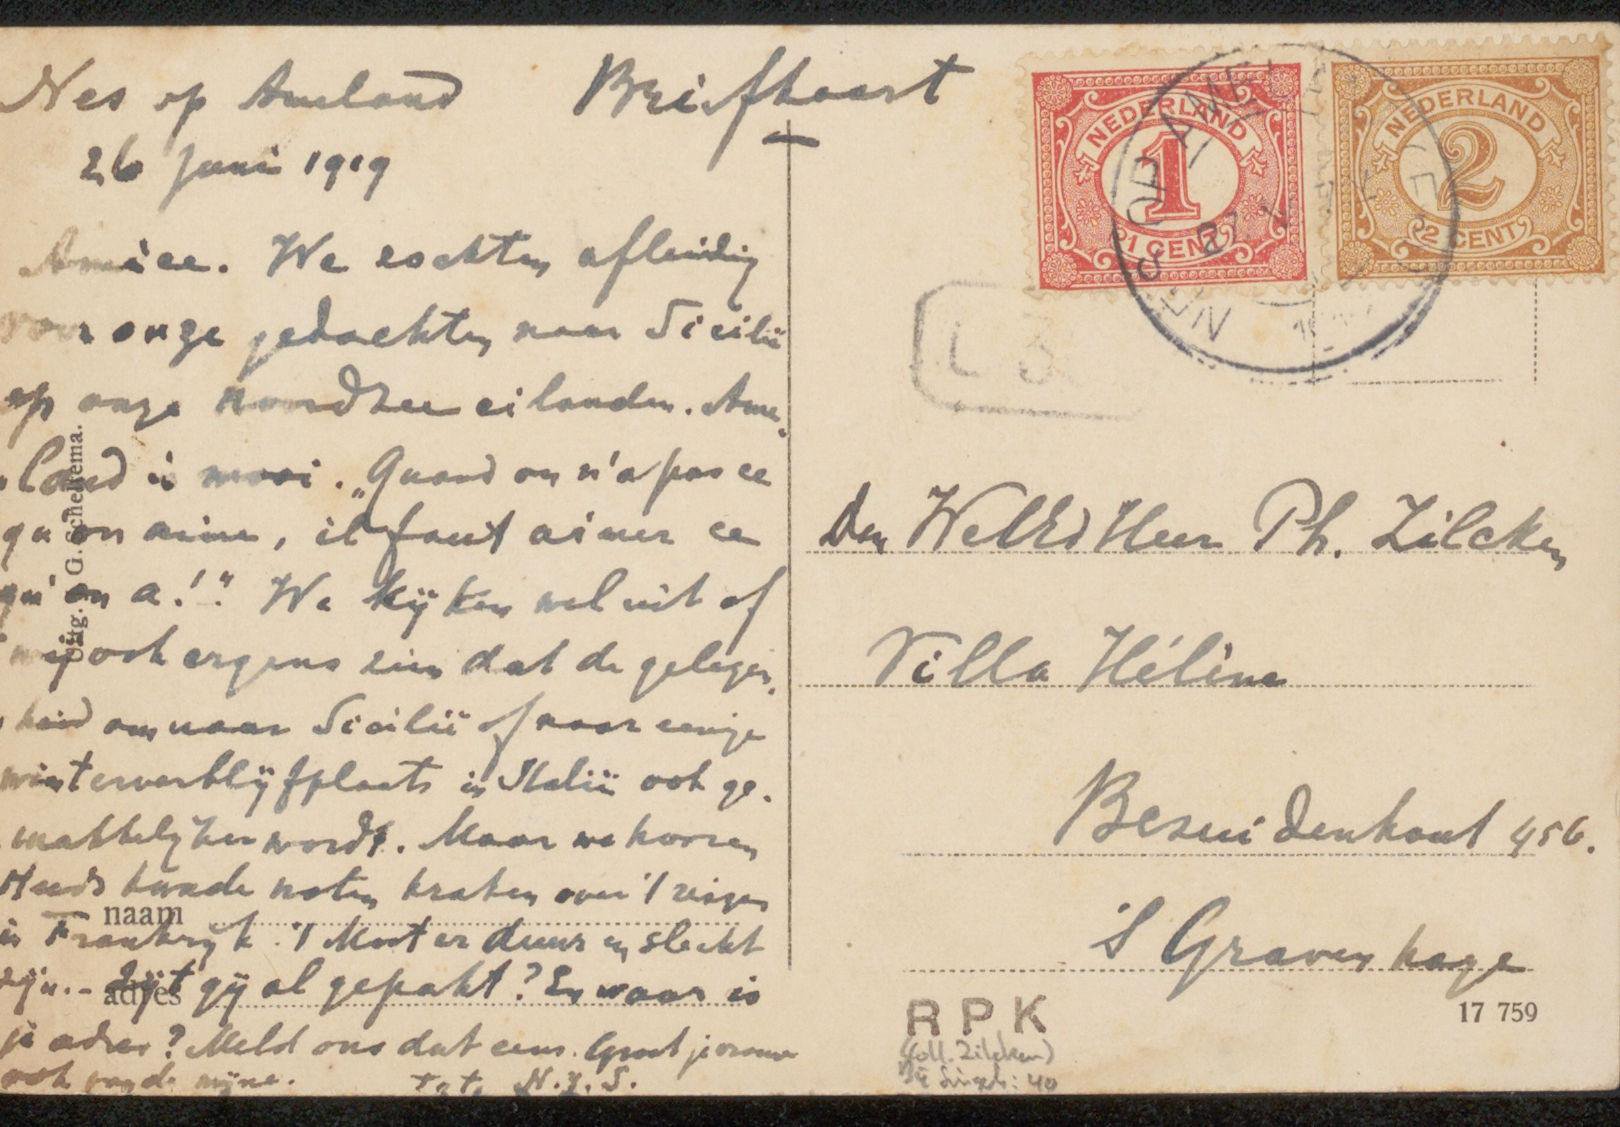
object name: ansichtkaart, prentbriefkaart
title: Prentbriefkaart aan Philip Zilcken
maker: n.j. singels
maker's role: leraar, schrijver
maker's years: 1857-1931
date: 1919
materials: cardboard, ink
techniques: photograph, pen, writing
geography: nes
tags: the hague, painter, draughtsman, philip zilcken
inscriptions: collector's mark: ‘RPK’